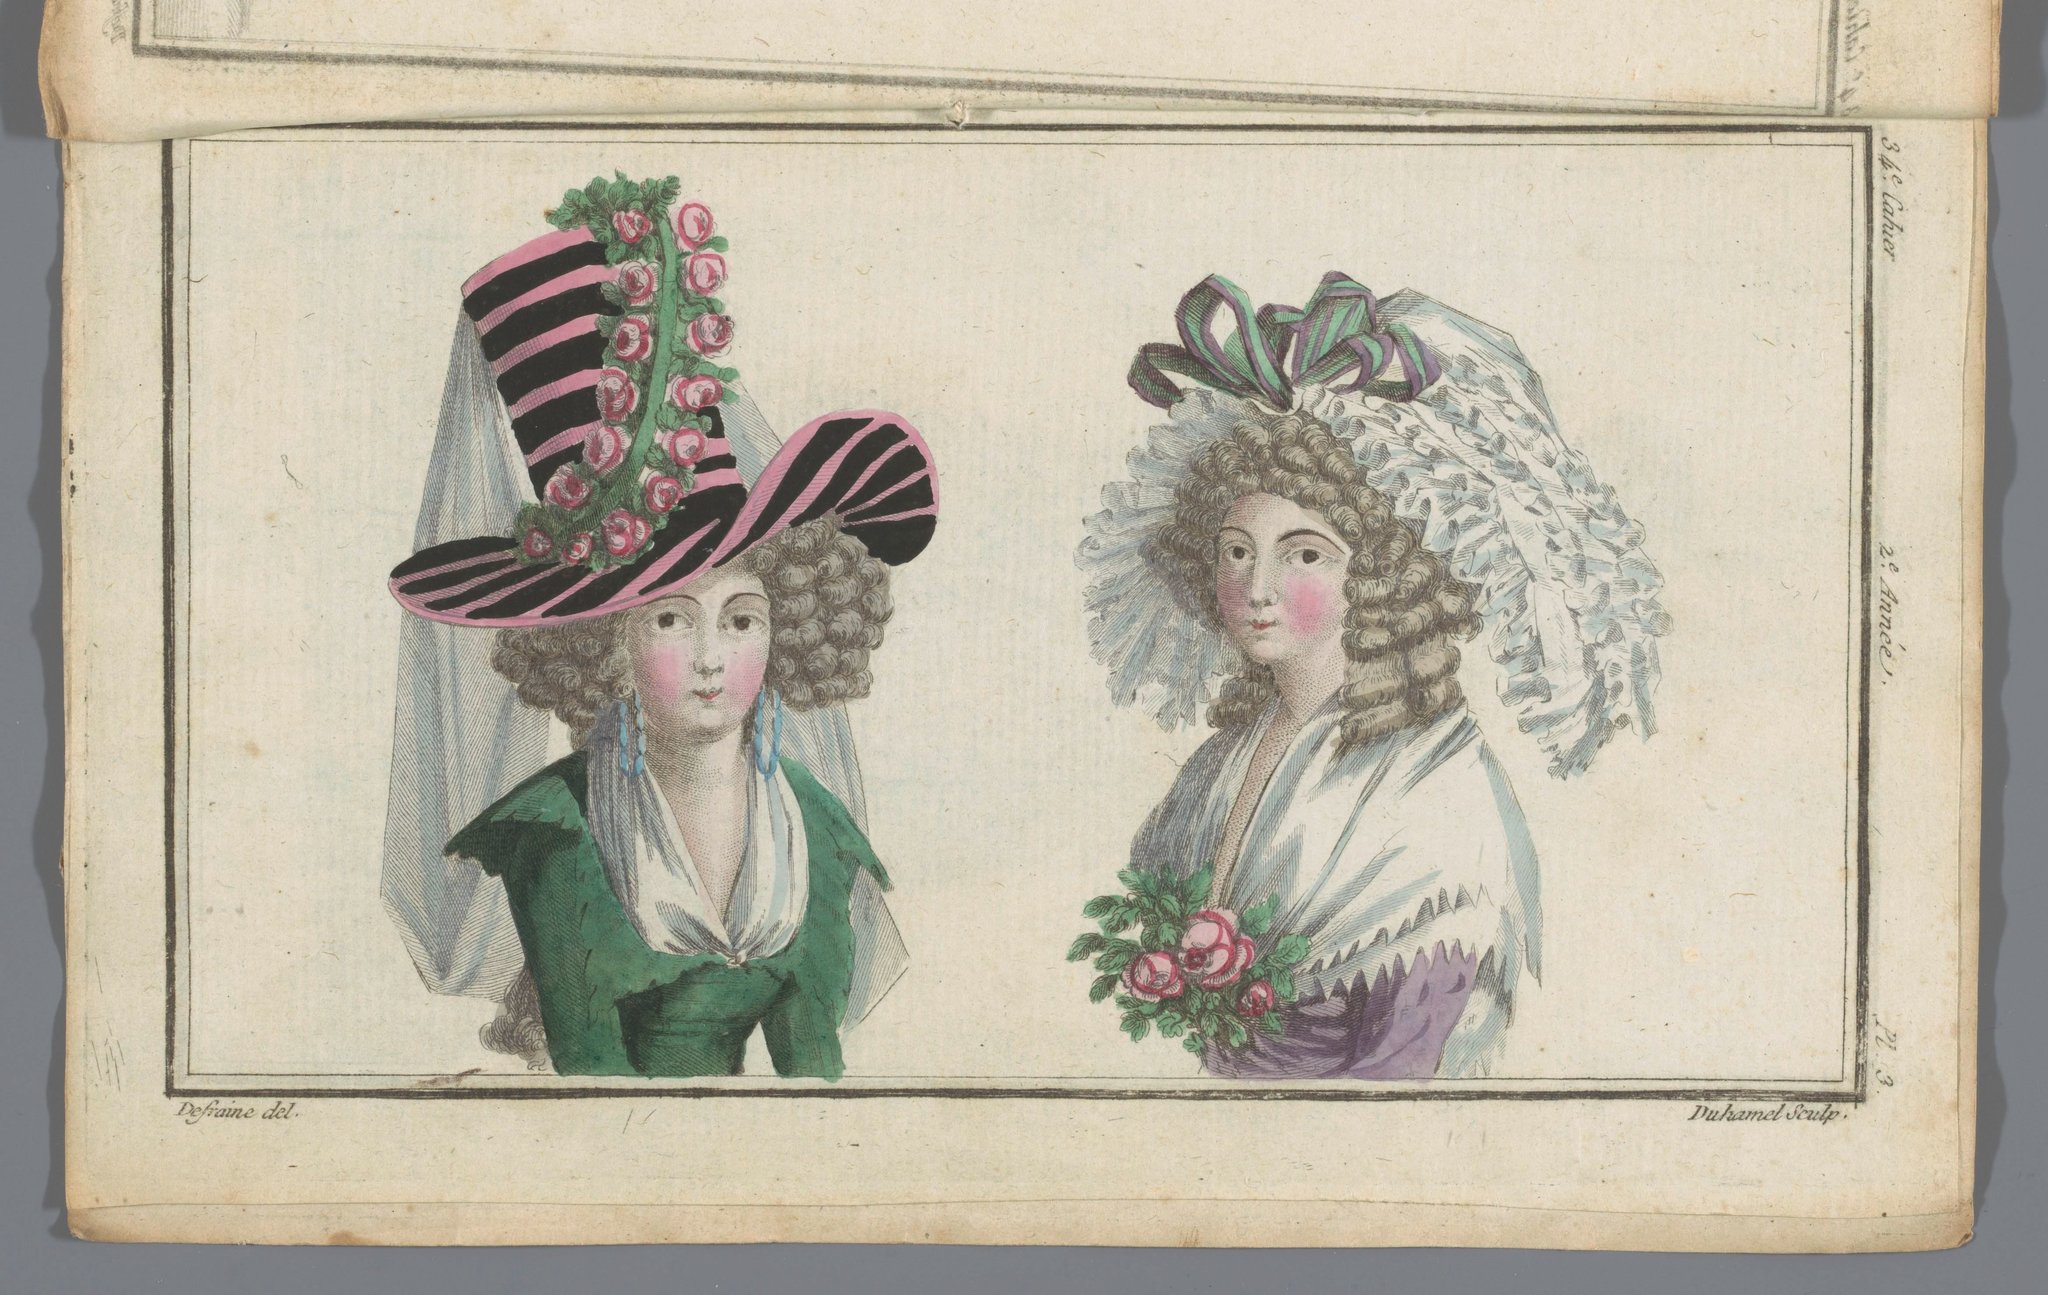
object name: fashion print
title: Magasin des Modes Nouvelles Françaises et Anglaises, 20 octobre 1787, 34e cahier, 2e année, Pl. 2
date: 1787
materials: paper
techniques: engraving, hand coloring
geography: paris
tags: clothing for the upper part of the body (caraco) (+ women's clothes), ear-rings (+ women's clothes), cut flowers; nosegay, bunch of flowers, gloves, mittens (long gloves) (+ women's clothes), neck-gear: collar (+ women's clothes), fashion plates, head-gear: hat (+ women's clothes), skirt (+ women's clothes), sleeves: cuffs (+ women's clothes), piece of clothing covering the breast or décolleté (fichu) (+ women's clothes)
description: Staande vrouw gekleed in een klaproosrode caracot (jakje) van gros de Naples met kraag, revers, zwart oplegsel en witte knopen. Hierbij een lijfje van paarse stof met een brede witte mousseline ceintuur en een zwarte rok versierd met rode stroken. Accessoires: 1 Een fichu van gaze. 2 Oorbellen van blauwe kralen (uit des Indes). 3 Kanariegele handschoenen. 4 Rode schoenen met zwarte strookjes. 5 Grote hoed van zwart vilt, versierd met een ladder van rood lint. 6 Getoupeerd kapsel met enkele losse krullen en van achter ‘à la Consieillière’.